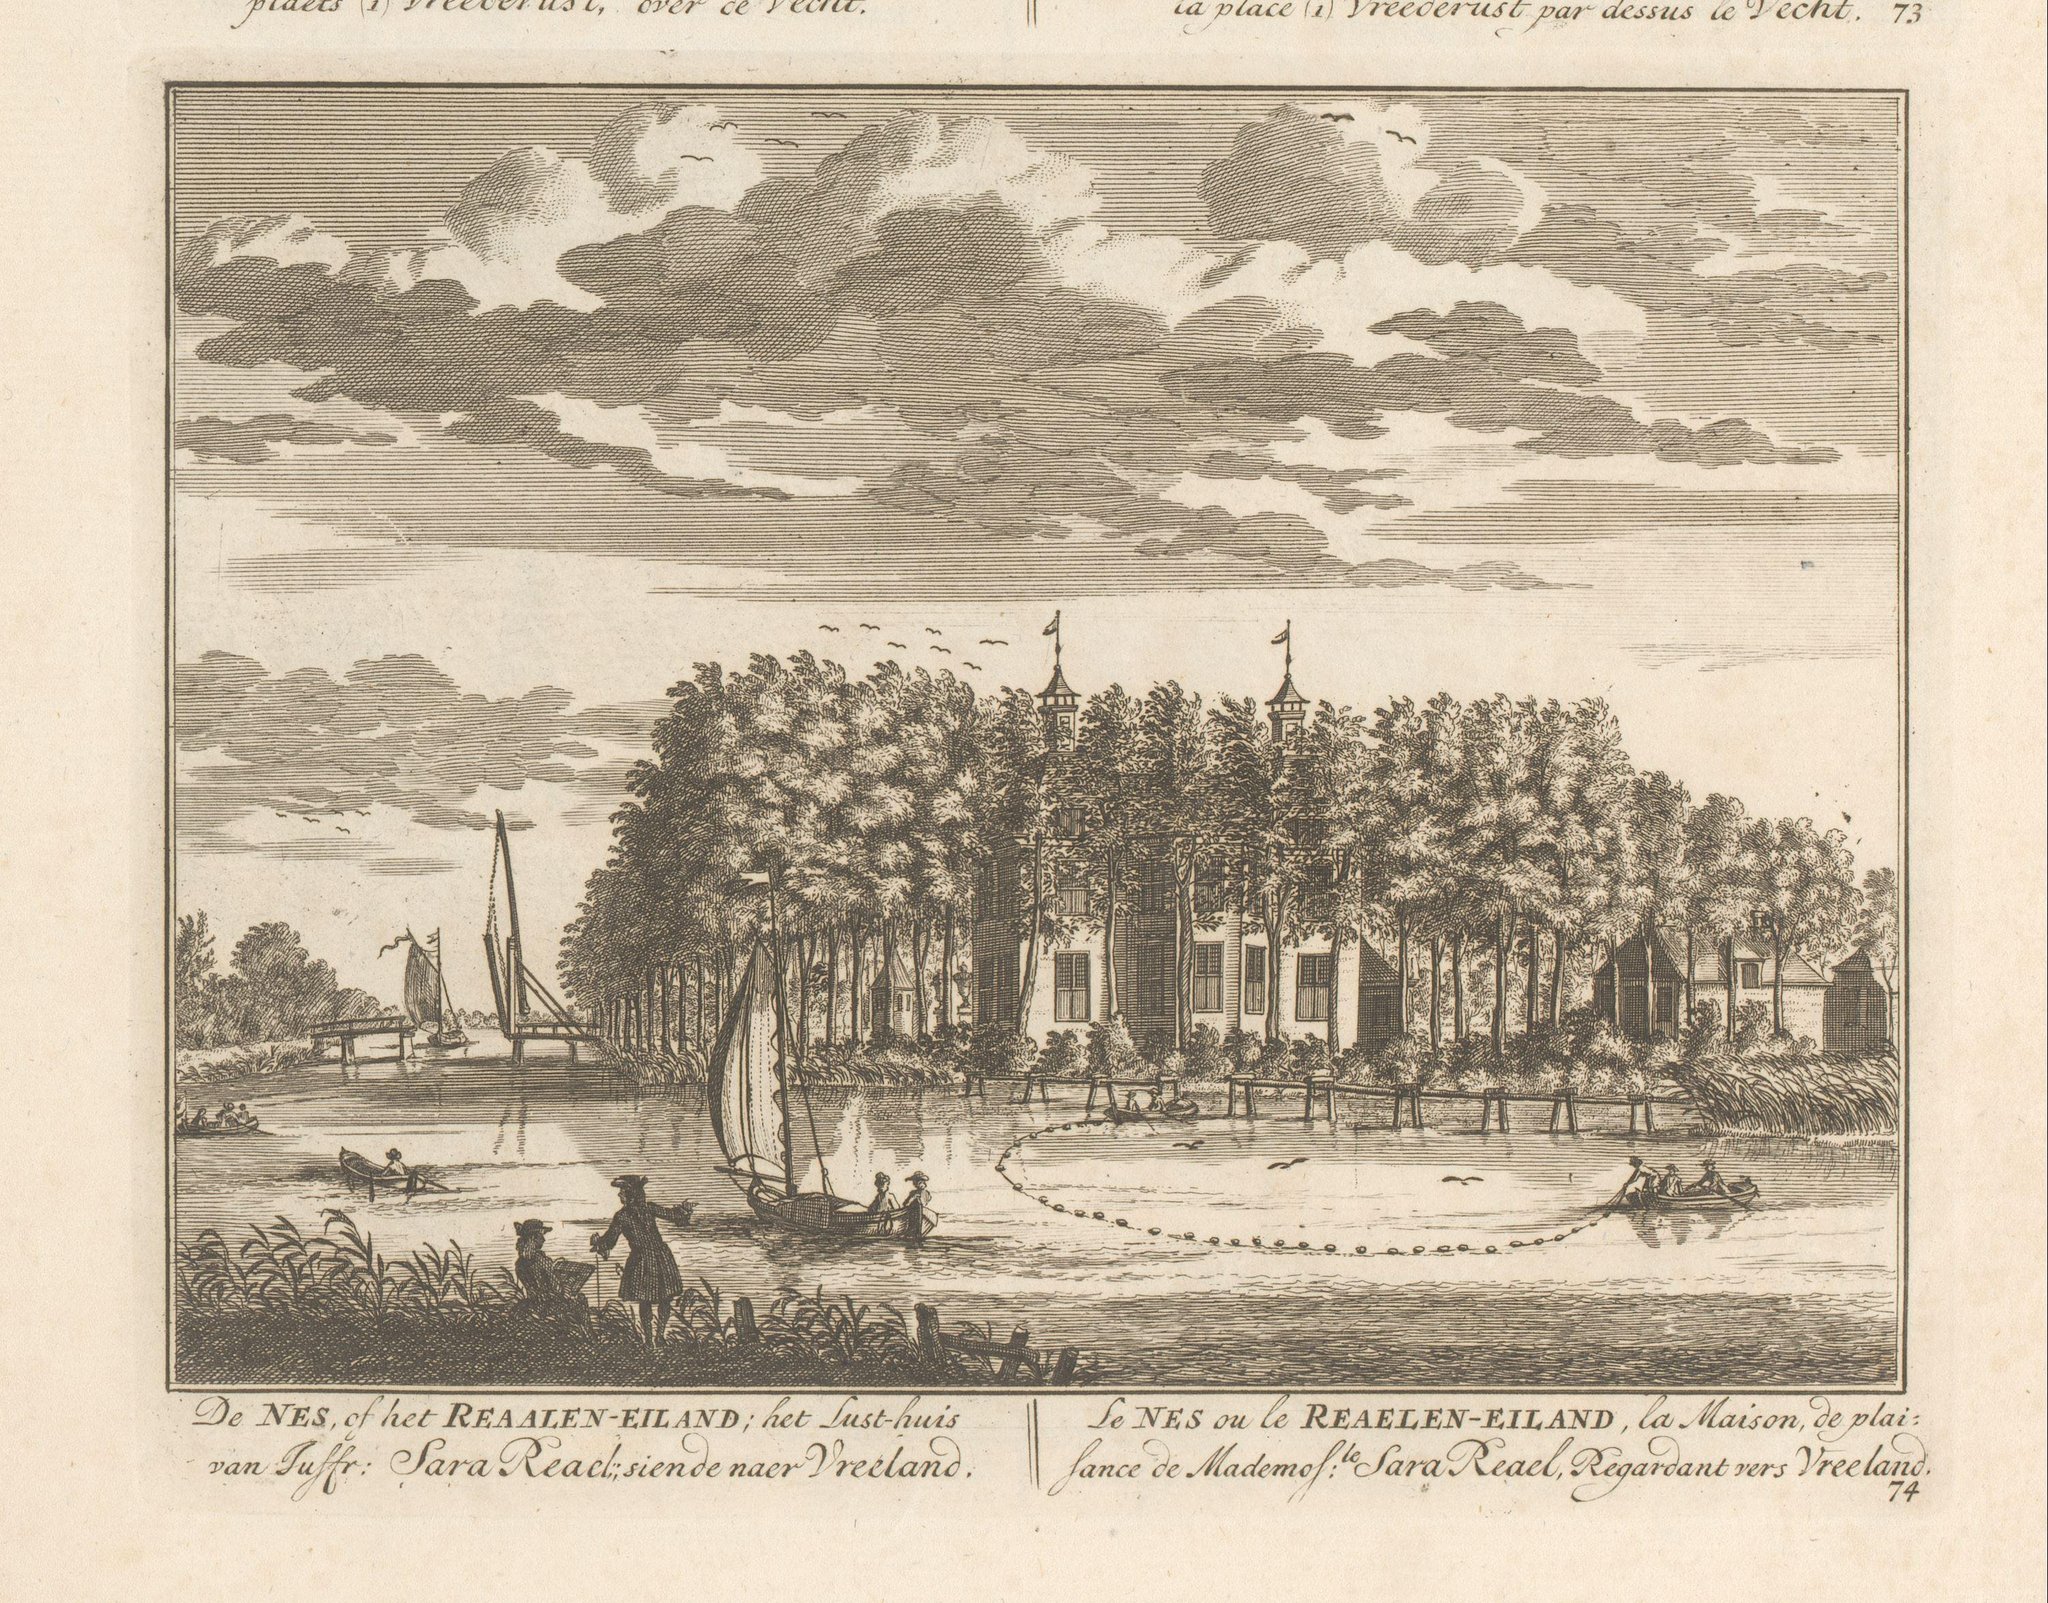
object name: print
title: Gezicht op de buitenplaats Realeneiland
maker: daniël stopendaal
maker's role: print maker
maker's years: 1672-1726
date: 1790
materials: paper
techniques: engraving, etching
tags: river (+ landscape with figures, staffage), country-house, vecht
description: Prent gebruikt in: Leth, Andries de. De zegepraalende Vecht, vertoonende verscheidene gesichten van lustplaatsen, heeren huysen en dorpen, beginnende van Uitrecht en met Muyden besluytende (...). Amsterdam: Weduwe Nicolaus Visscher, 1719. Prent ook gebruikt in: Brouërius van Nidek, Matthaeus. De Vechtstroom, van Utrecht tot Muiden (...). Amsterdam: H. Gartman, W. Vermandel en J.W. Smit, 1790.